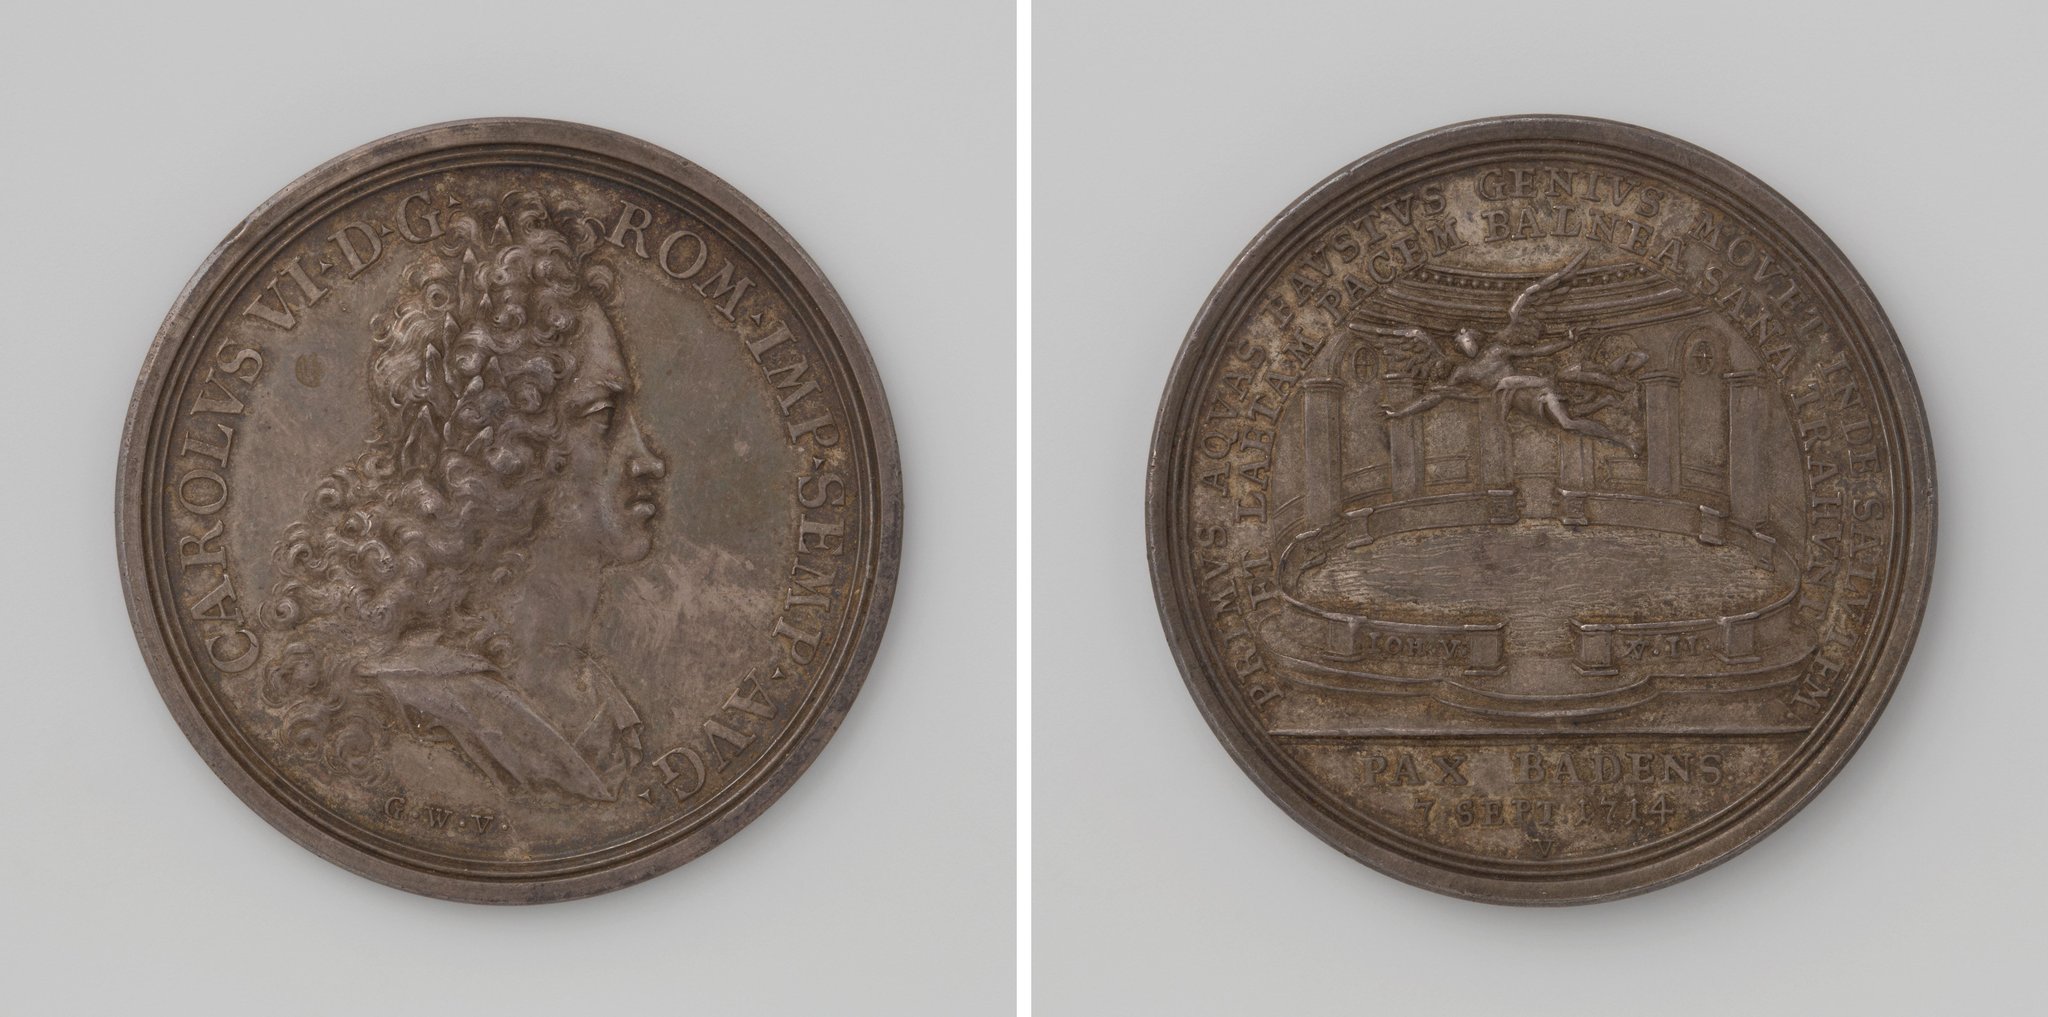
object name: history medal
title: Vrede van Baden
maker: georg wilhelm vestner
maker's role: medailleur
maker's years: 1677-1740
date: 1714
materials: silver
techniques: striking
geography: nuremberg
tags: vienna, charles vi (holy roman emperor), switzerland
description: Zilveren penning. Voorzijde: borststuk man met lauwerkrans binnen omschrift. Keerzijde: vredesengel daalt af naar de Jeruzalemse schaapspoel Bethsaida binnen omschrift; afsnede: opschrift